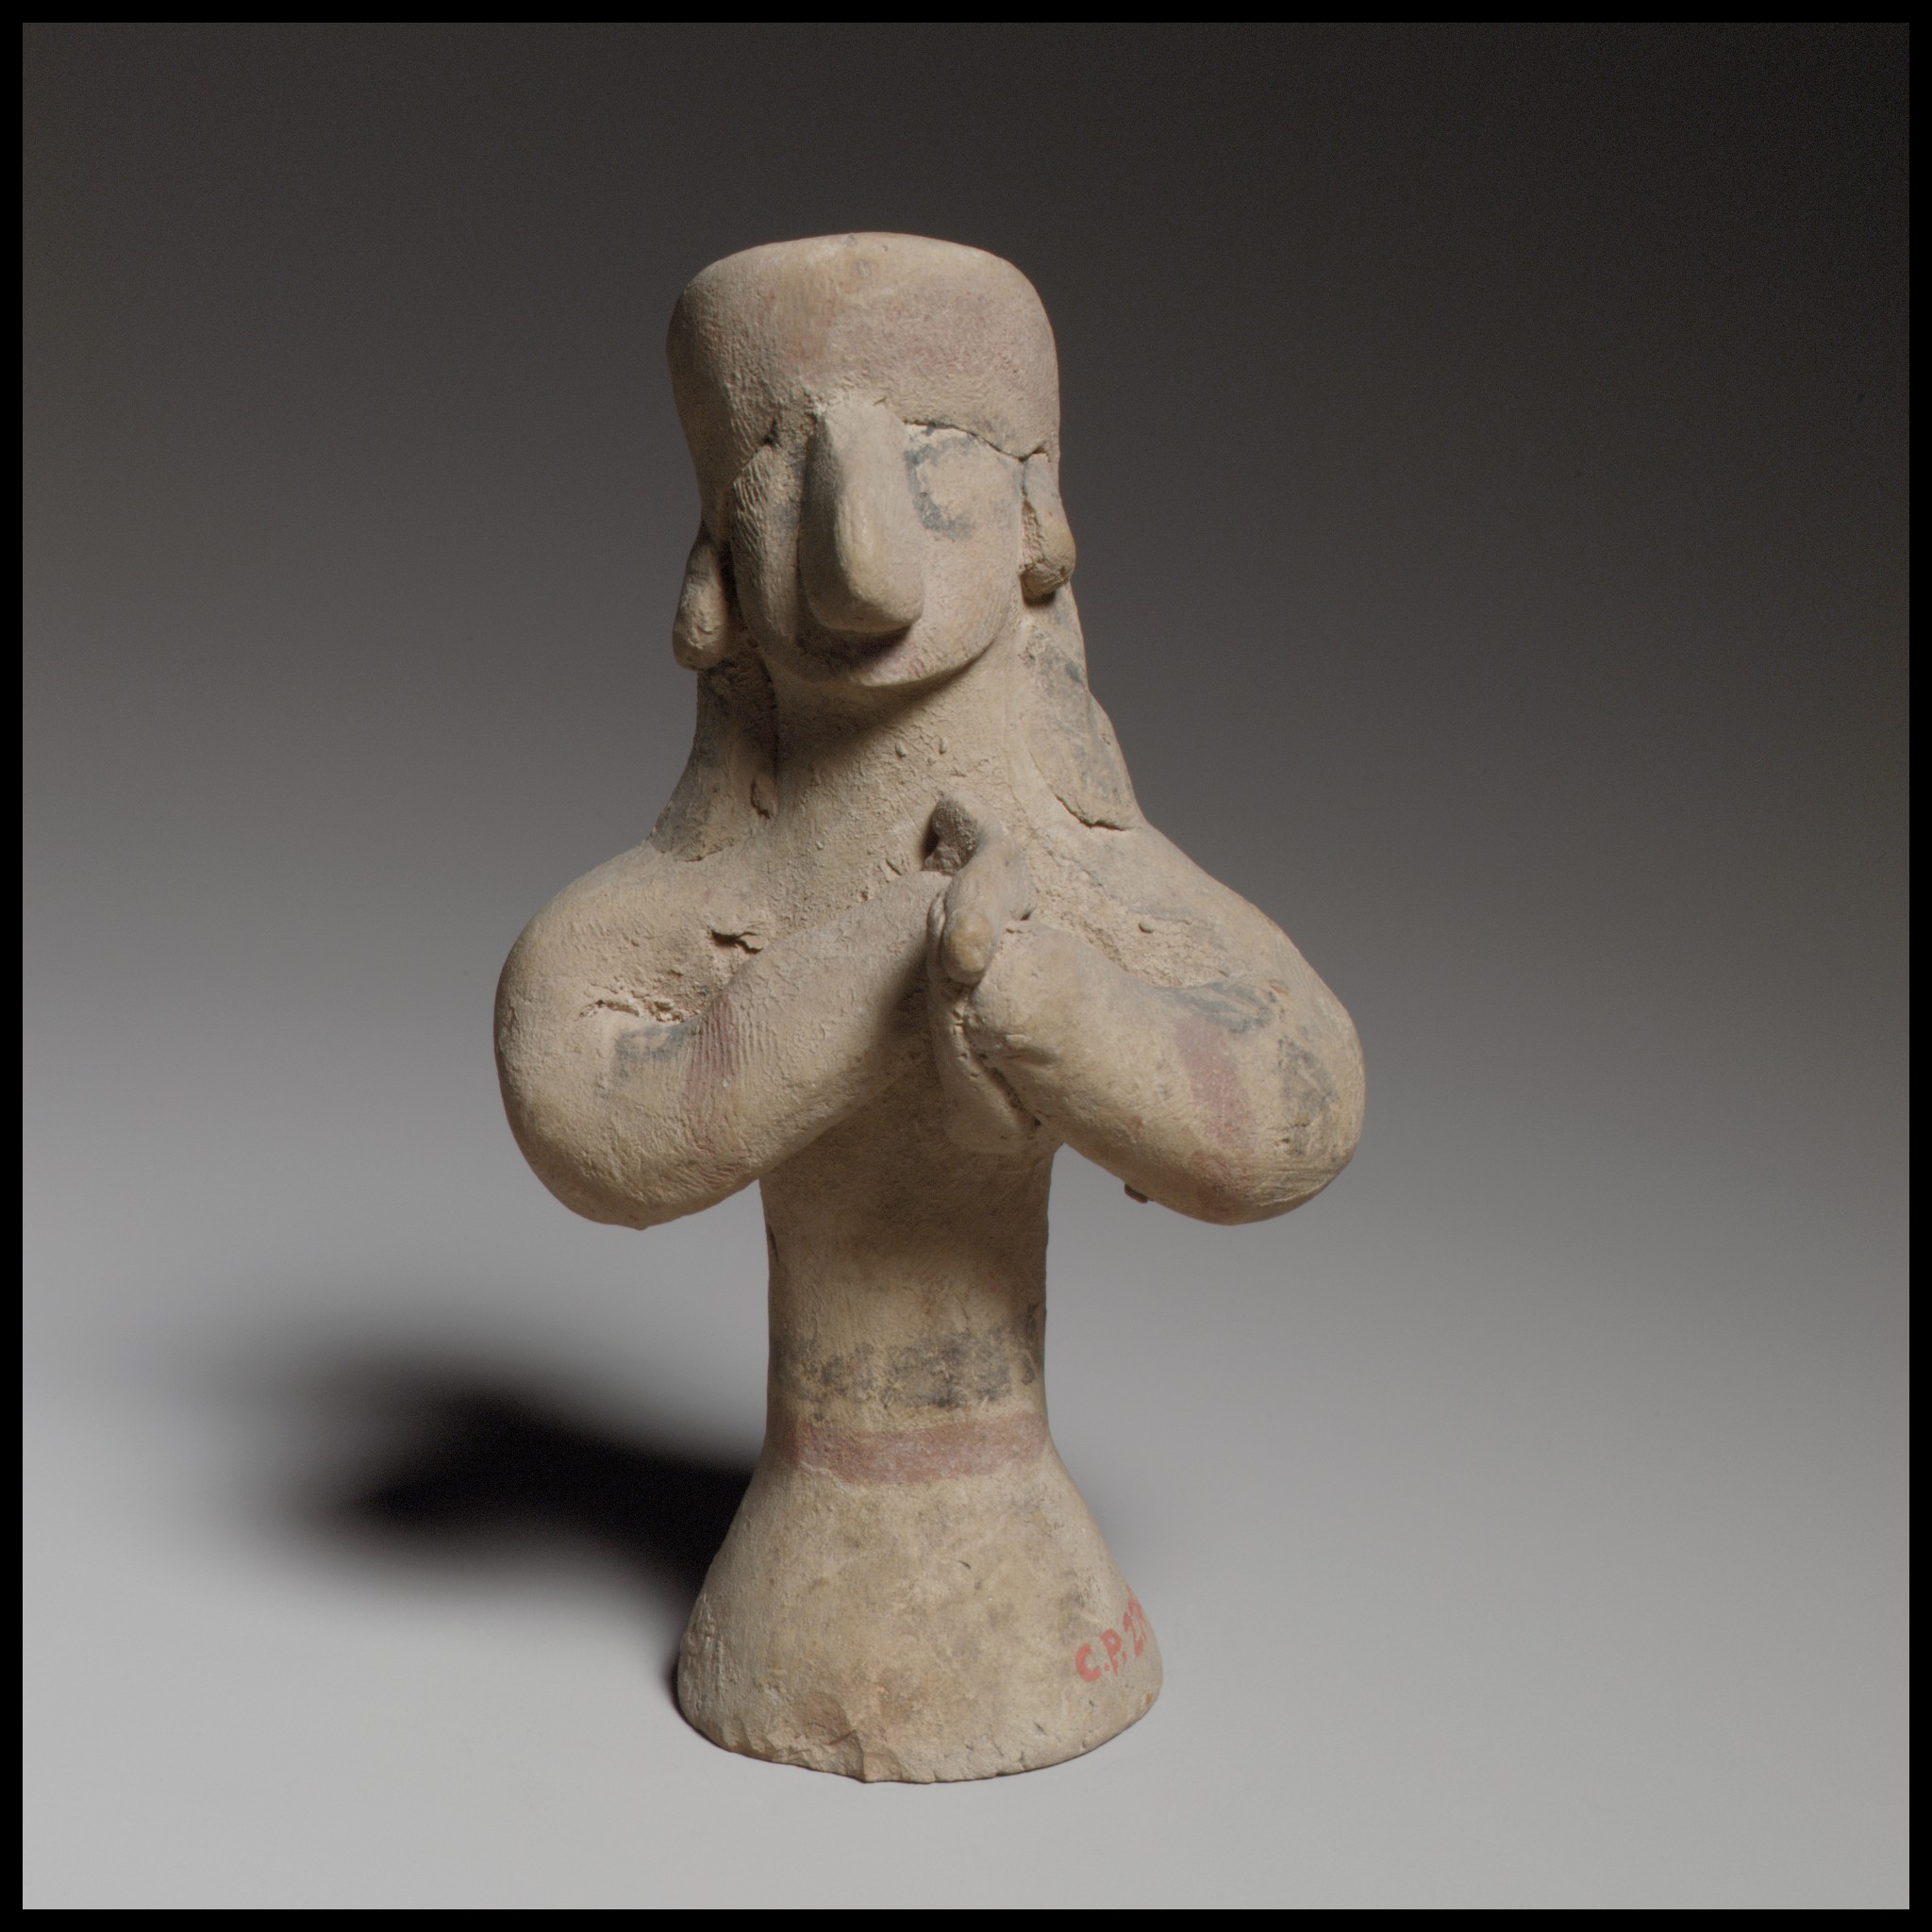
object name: statuette of a votary playing lyre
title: Standing male lyre player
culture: cypriot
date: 600-480 BCE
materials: terracotta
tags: musical instruments,men